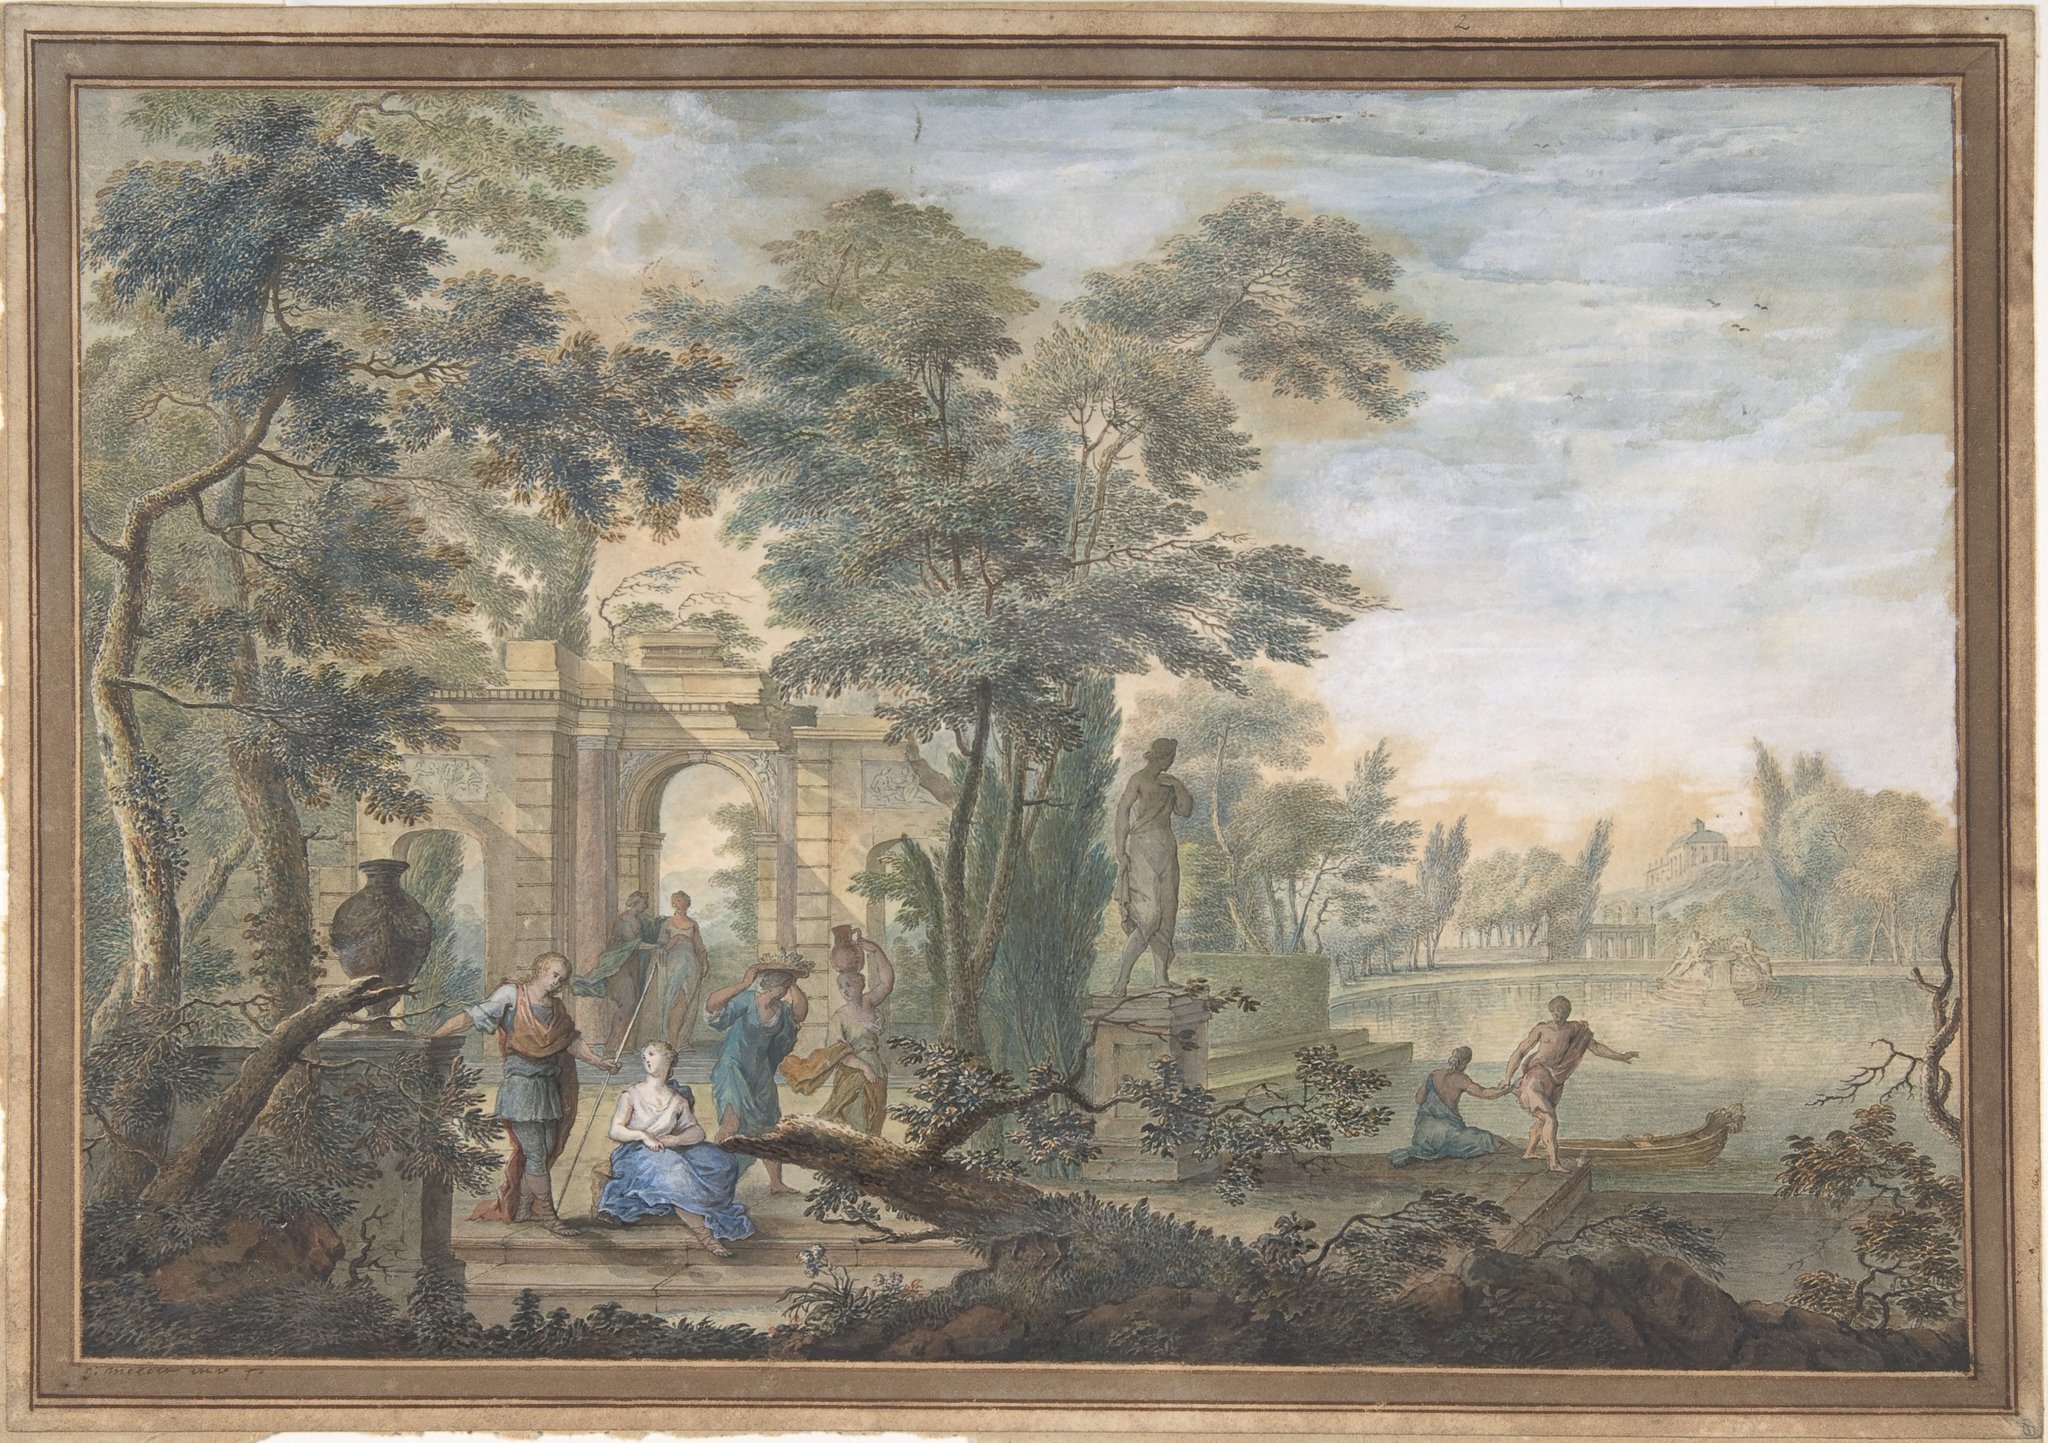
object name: drawing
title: Arcadian Landscape with several Figures and a Statue of Diana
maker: gerard melder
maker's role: artist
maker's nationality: dutch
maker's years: 1693-1754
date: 1701-1800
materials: gouache, watercolor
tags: men,women,diana,landscapes